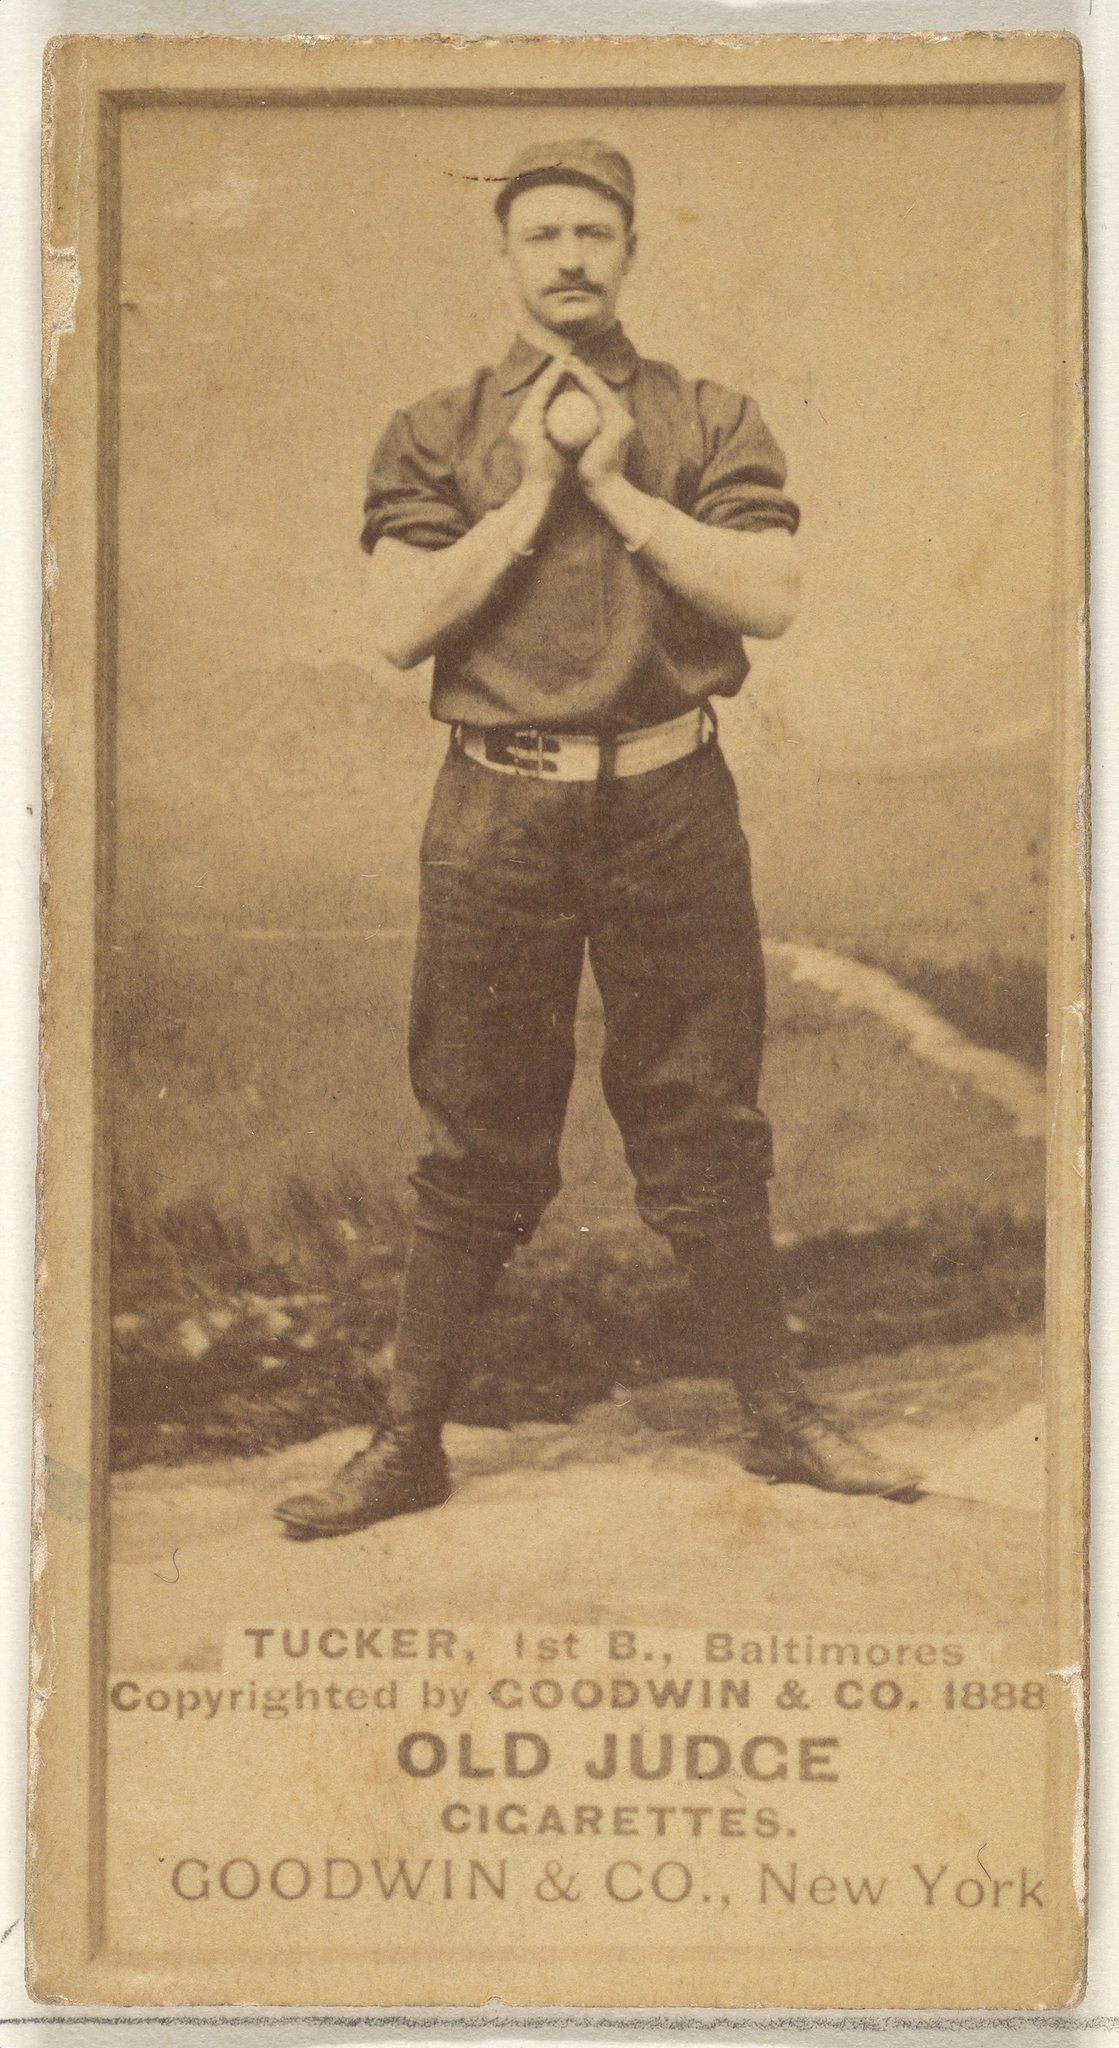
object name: baseball card, photograph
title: Tucker, 1st Base, Baltimore Orioles, from the Old Judge series (N172) for Old Judge Cigarettes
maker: goodwin & company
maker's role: publisher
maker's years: 1850-1950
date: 1888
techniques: albumen silver print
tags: men,portraits,baseball,athletes